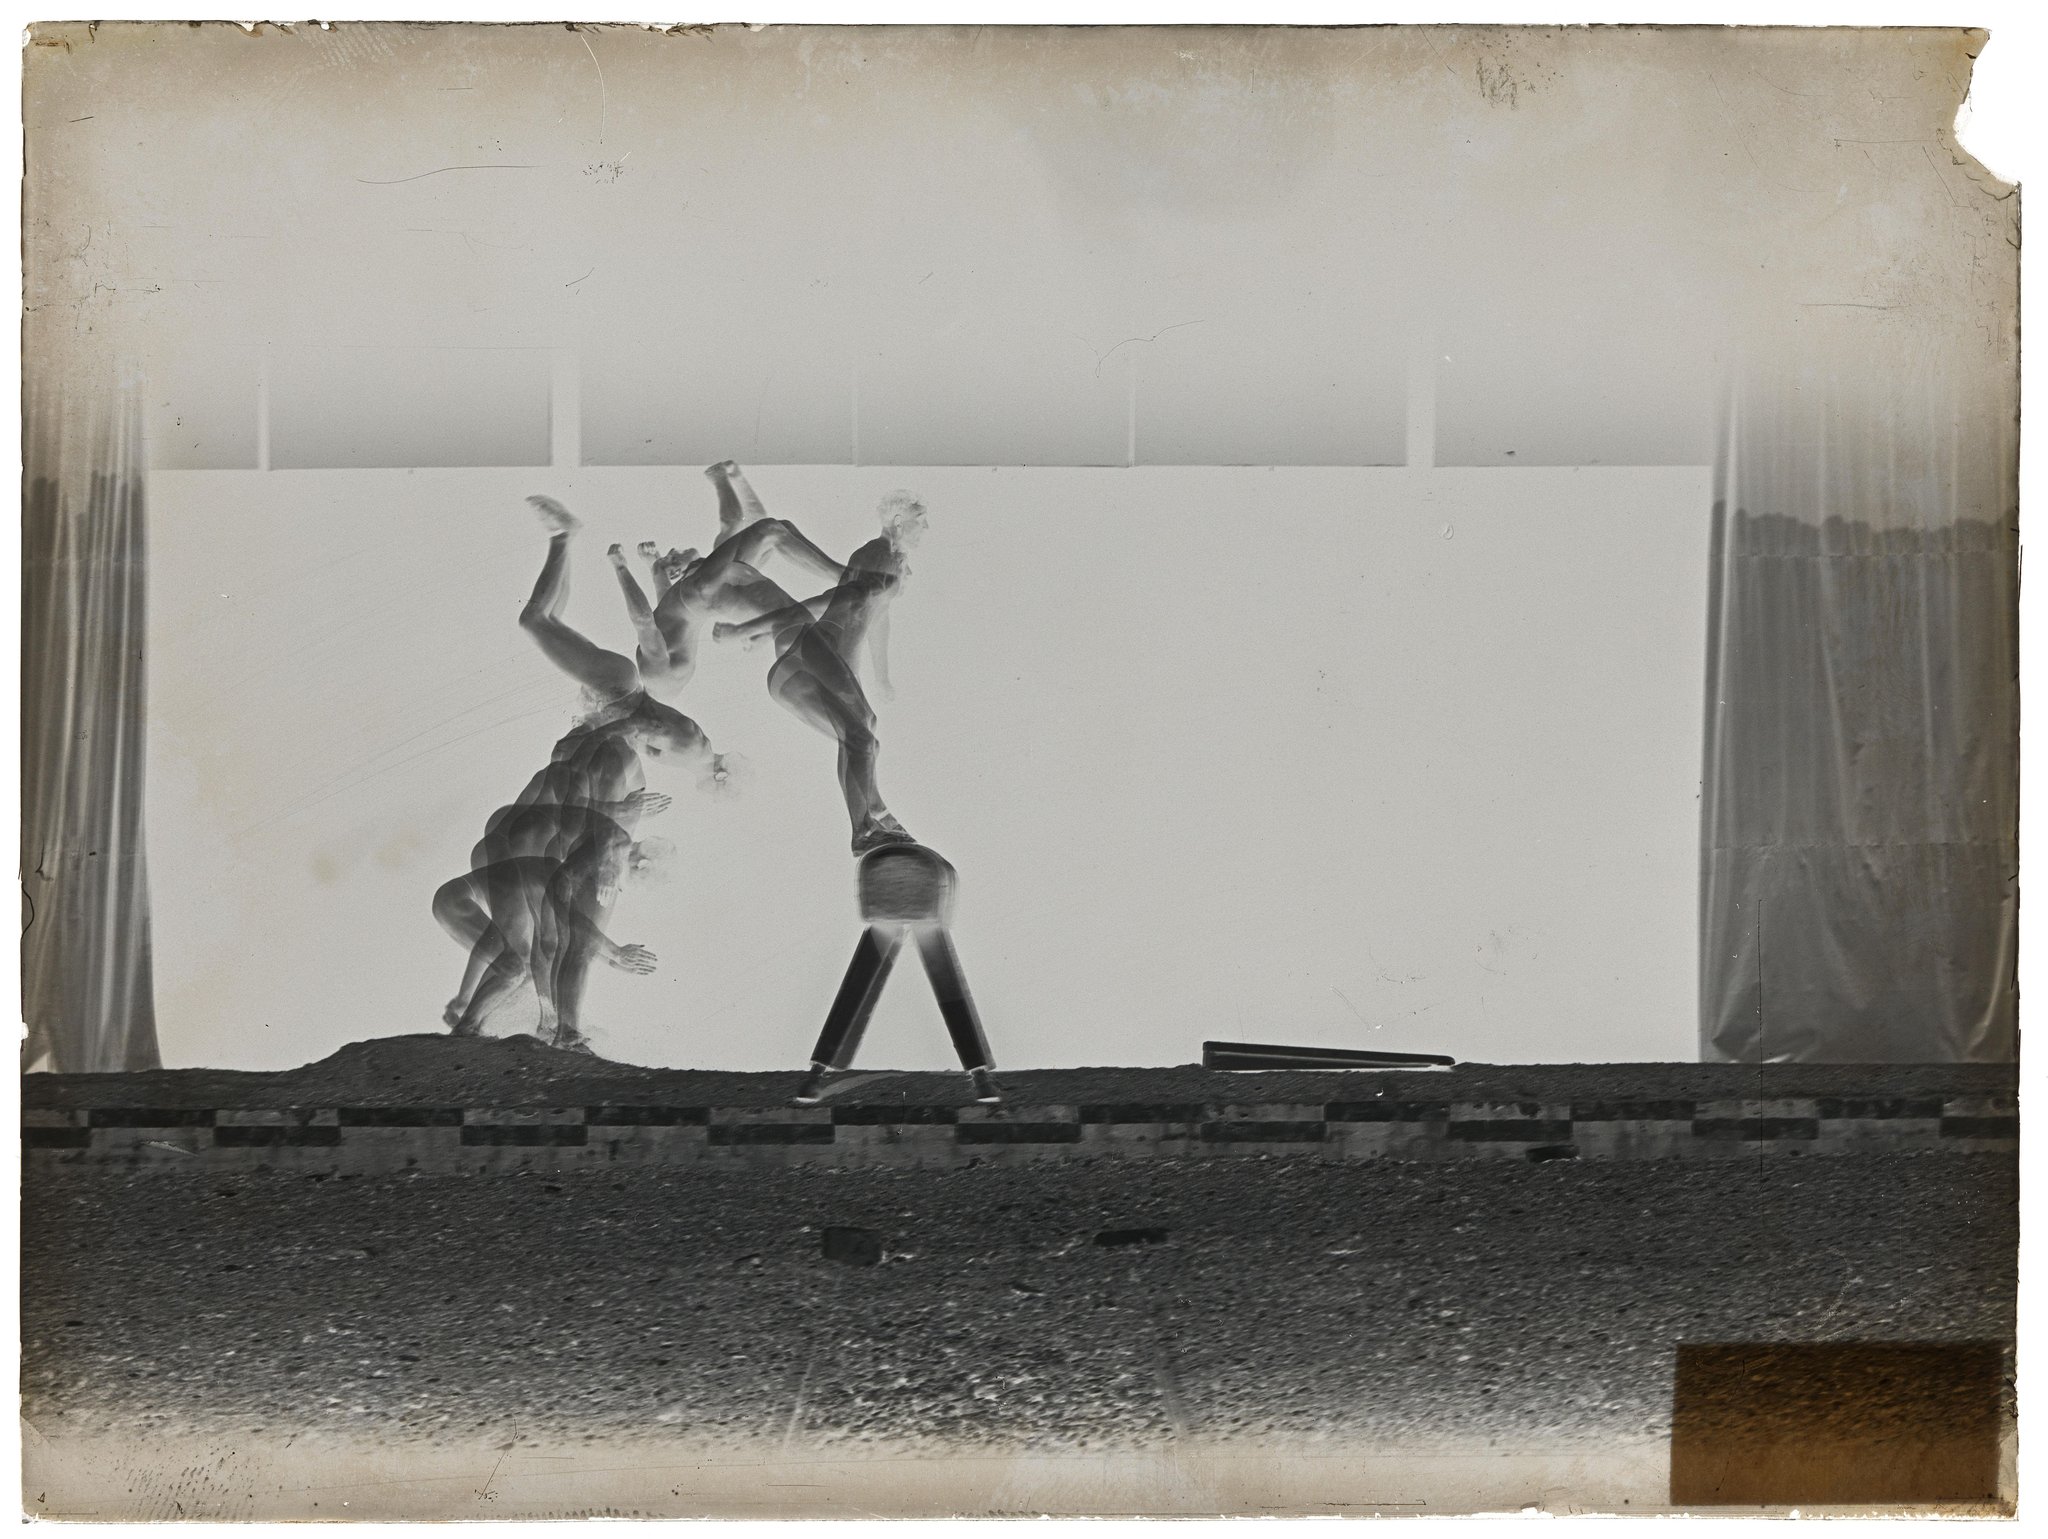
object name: glasnegatief, glasplaatnegatief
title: Man neemt achterwaartse sprong vanaf de bok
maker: étienne-jules marey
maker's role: fotograaf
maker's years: 1830-1904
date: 1882-1890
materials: glass, paper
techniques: gelatin glass negative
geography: france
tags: vaulting horse (gymnastics), adult man, automobile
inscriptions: inscription: ‘Ki 14’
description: Bij de negatieven zijn ook de duplicaatnegatieven en moderne afdrukken die voor de boekpublicatie vervaardigd zijn.